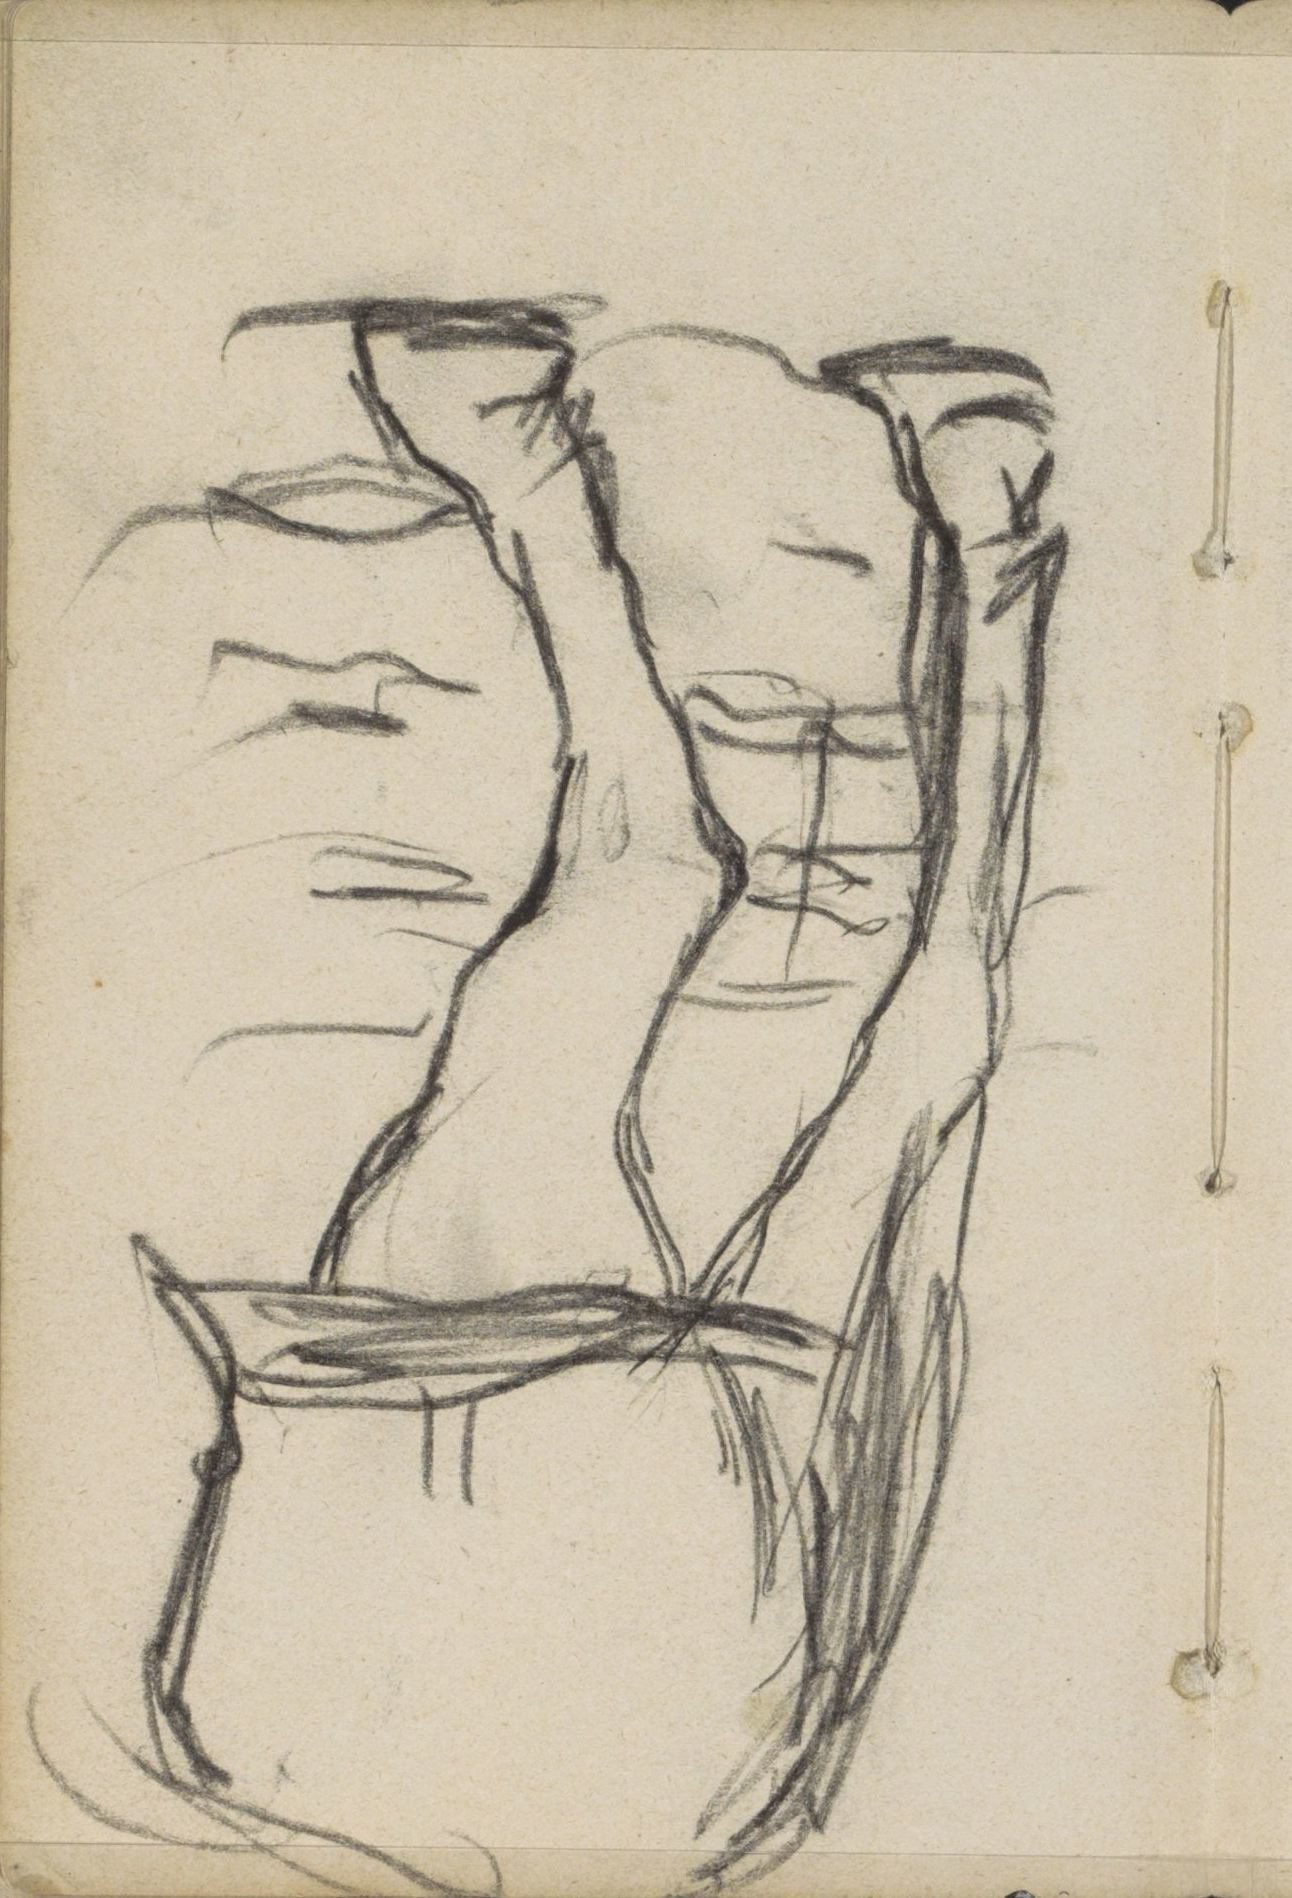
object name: sketchbook leaf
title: Achterlijf van een aangespannen paard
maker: george hendrik breitner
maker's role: draughtsman, painter, print maker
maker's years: 1857-1923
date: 1903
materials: chalk, paper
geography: amsterdam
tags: horse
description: Achterlijf van een aangespannen paard. Pagina 83 uit een schetsboek met 46 bladen.